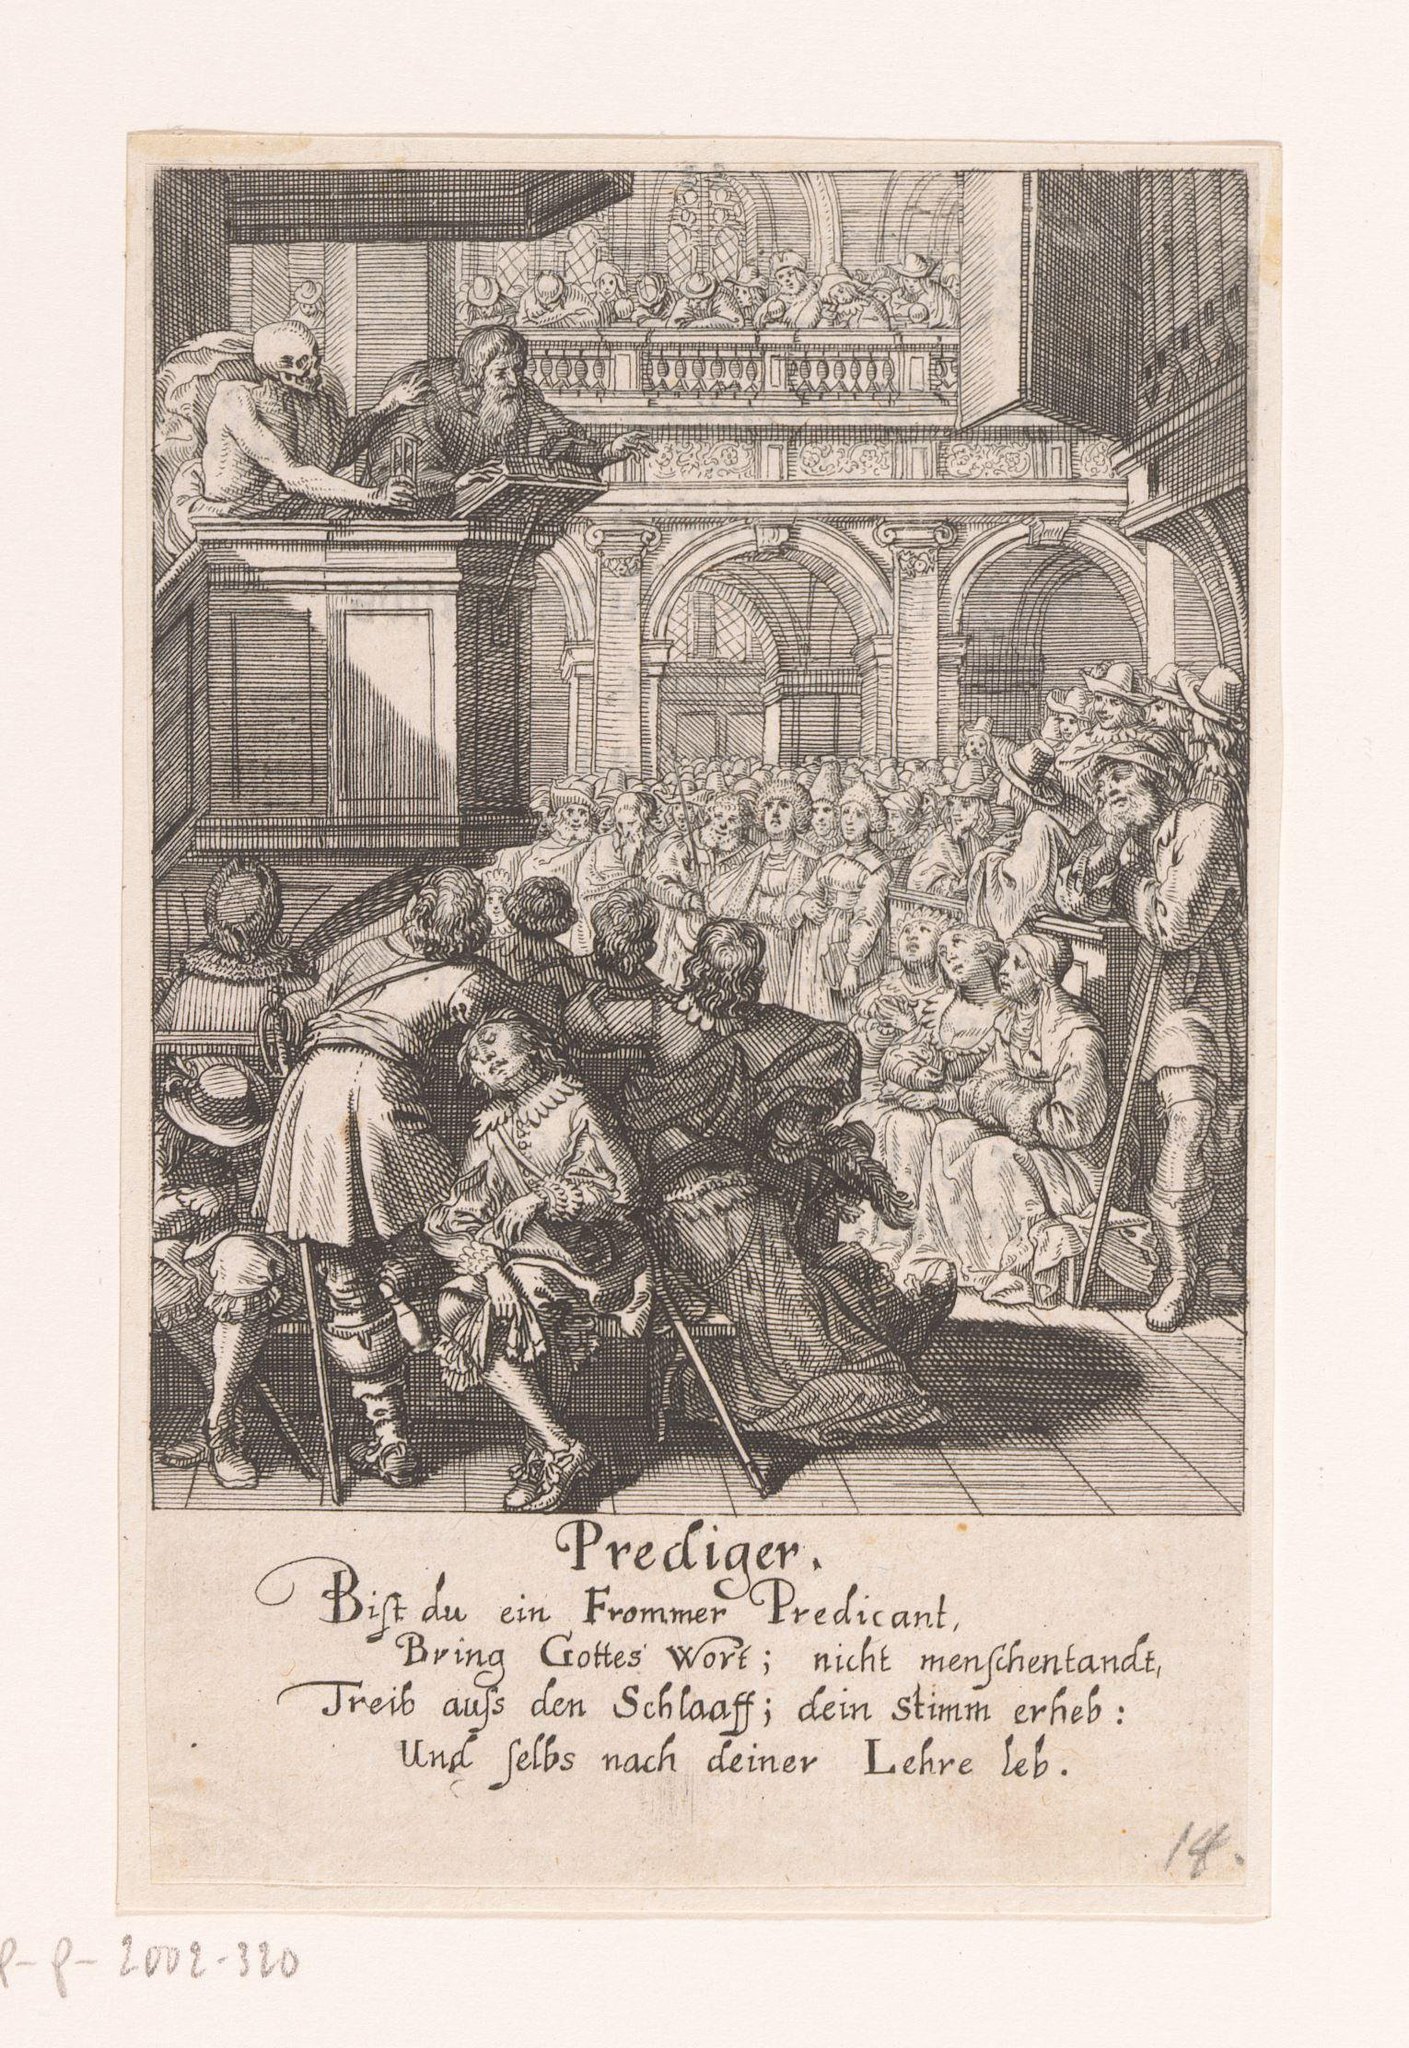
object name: book illustration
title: Predikant en de Dood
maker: johann jakob bodmer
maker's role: printer, publisher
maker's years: 1629-1650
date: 1650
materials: paper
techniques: etching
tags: personifications of death; 'morte' (ripa), dance of death; death together with one or more human beings, preaching (in general)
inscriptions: collector's mark: Lugt 2233, collector's mark: Lugt 2228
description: Prent uit: Meyer, Rudolph. Sterbenspiegel, das ist sonnenklare Vorstellung menschlicher Nichtigkeit durch alle Ständ und Geschlechter (...). Zürich: J.J. Bodmer, 1650.